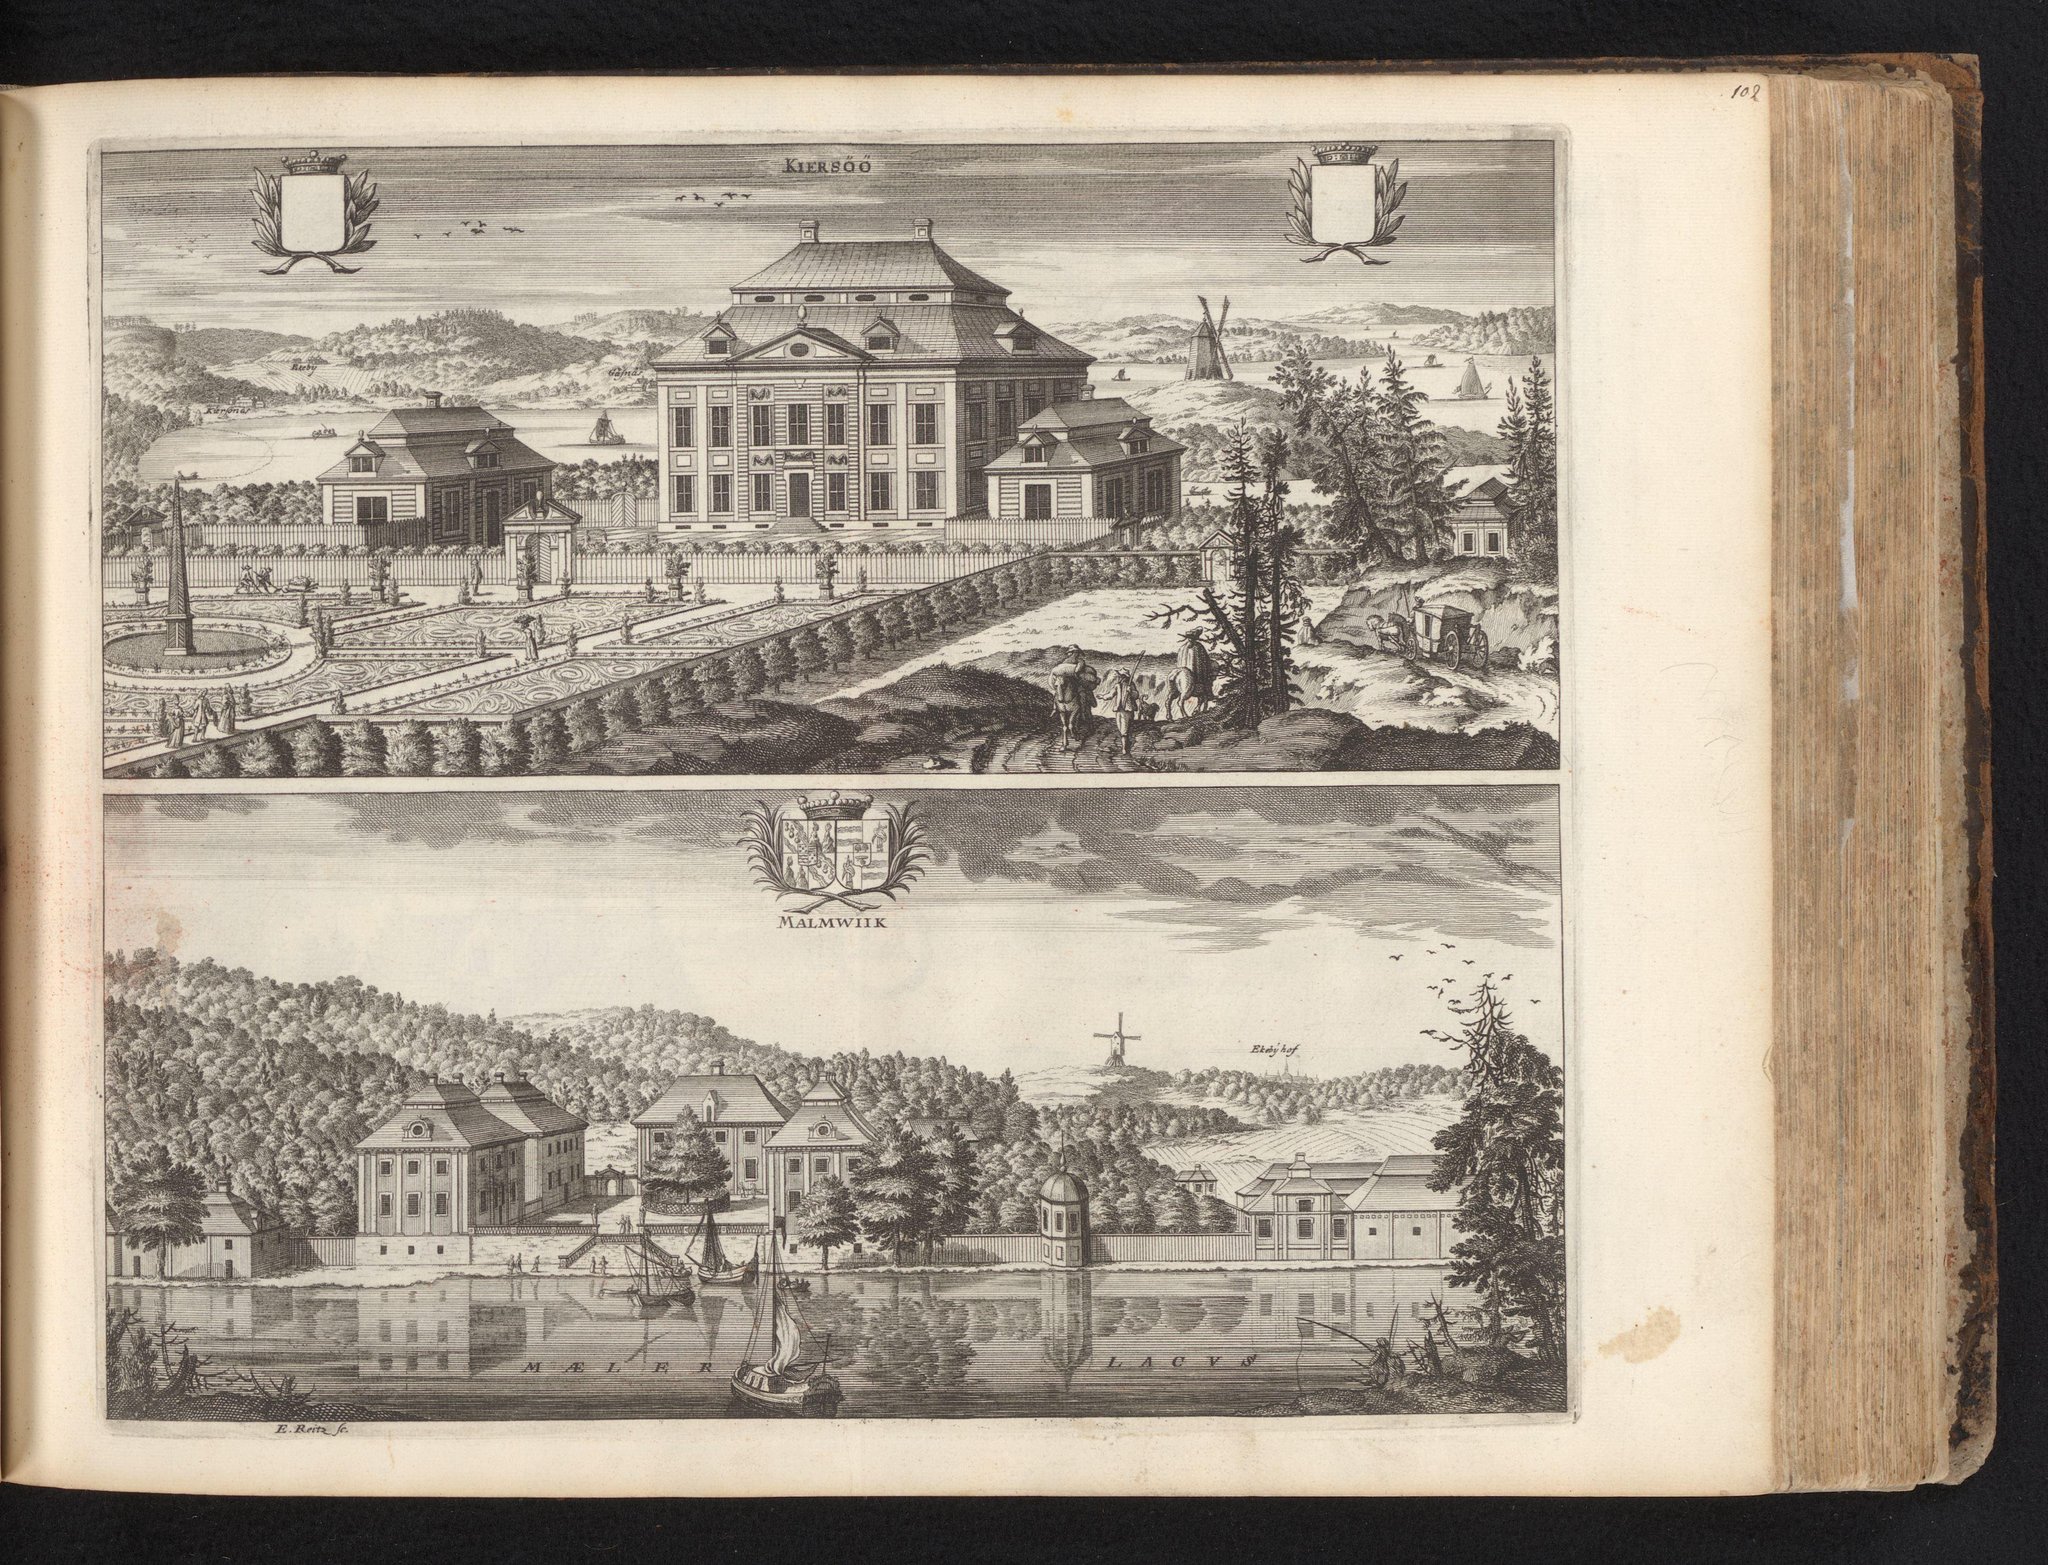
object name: album leaf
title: Kiersöö / Malmwiik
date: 1695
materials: paper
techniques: etching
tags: garden, housing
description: Kungliga Biblioteket, 'Suecia': http://www.kb.se/samlingarna/Kartor-bilder/Suecia-antiqua/ (geraadpleegd november 2016).